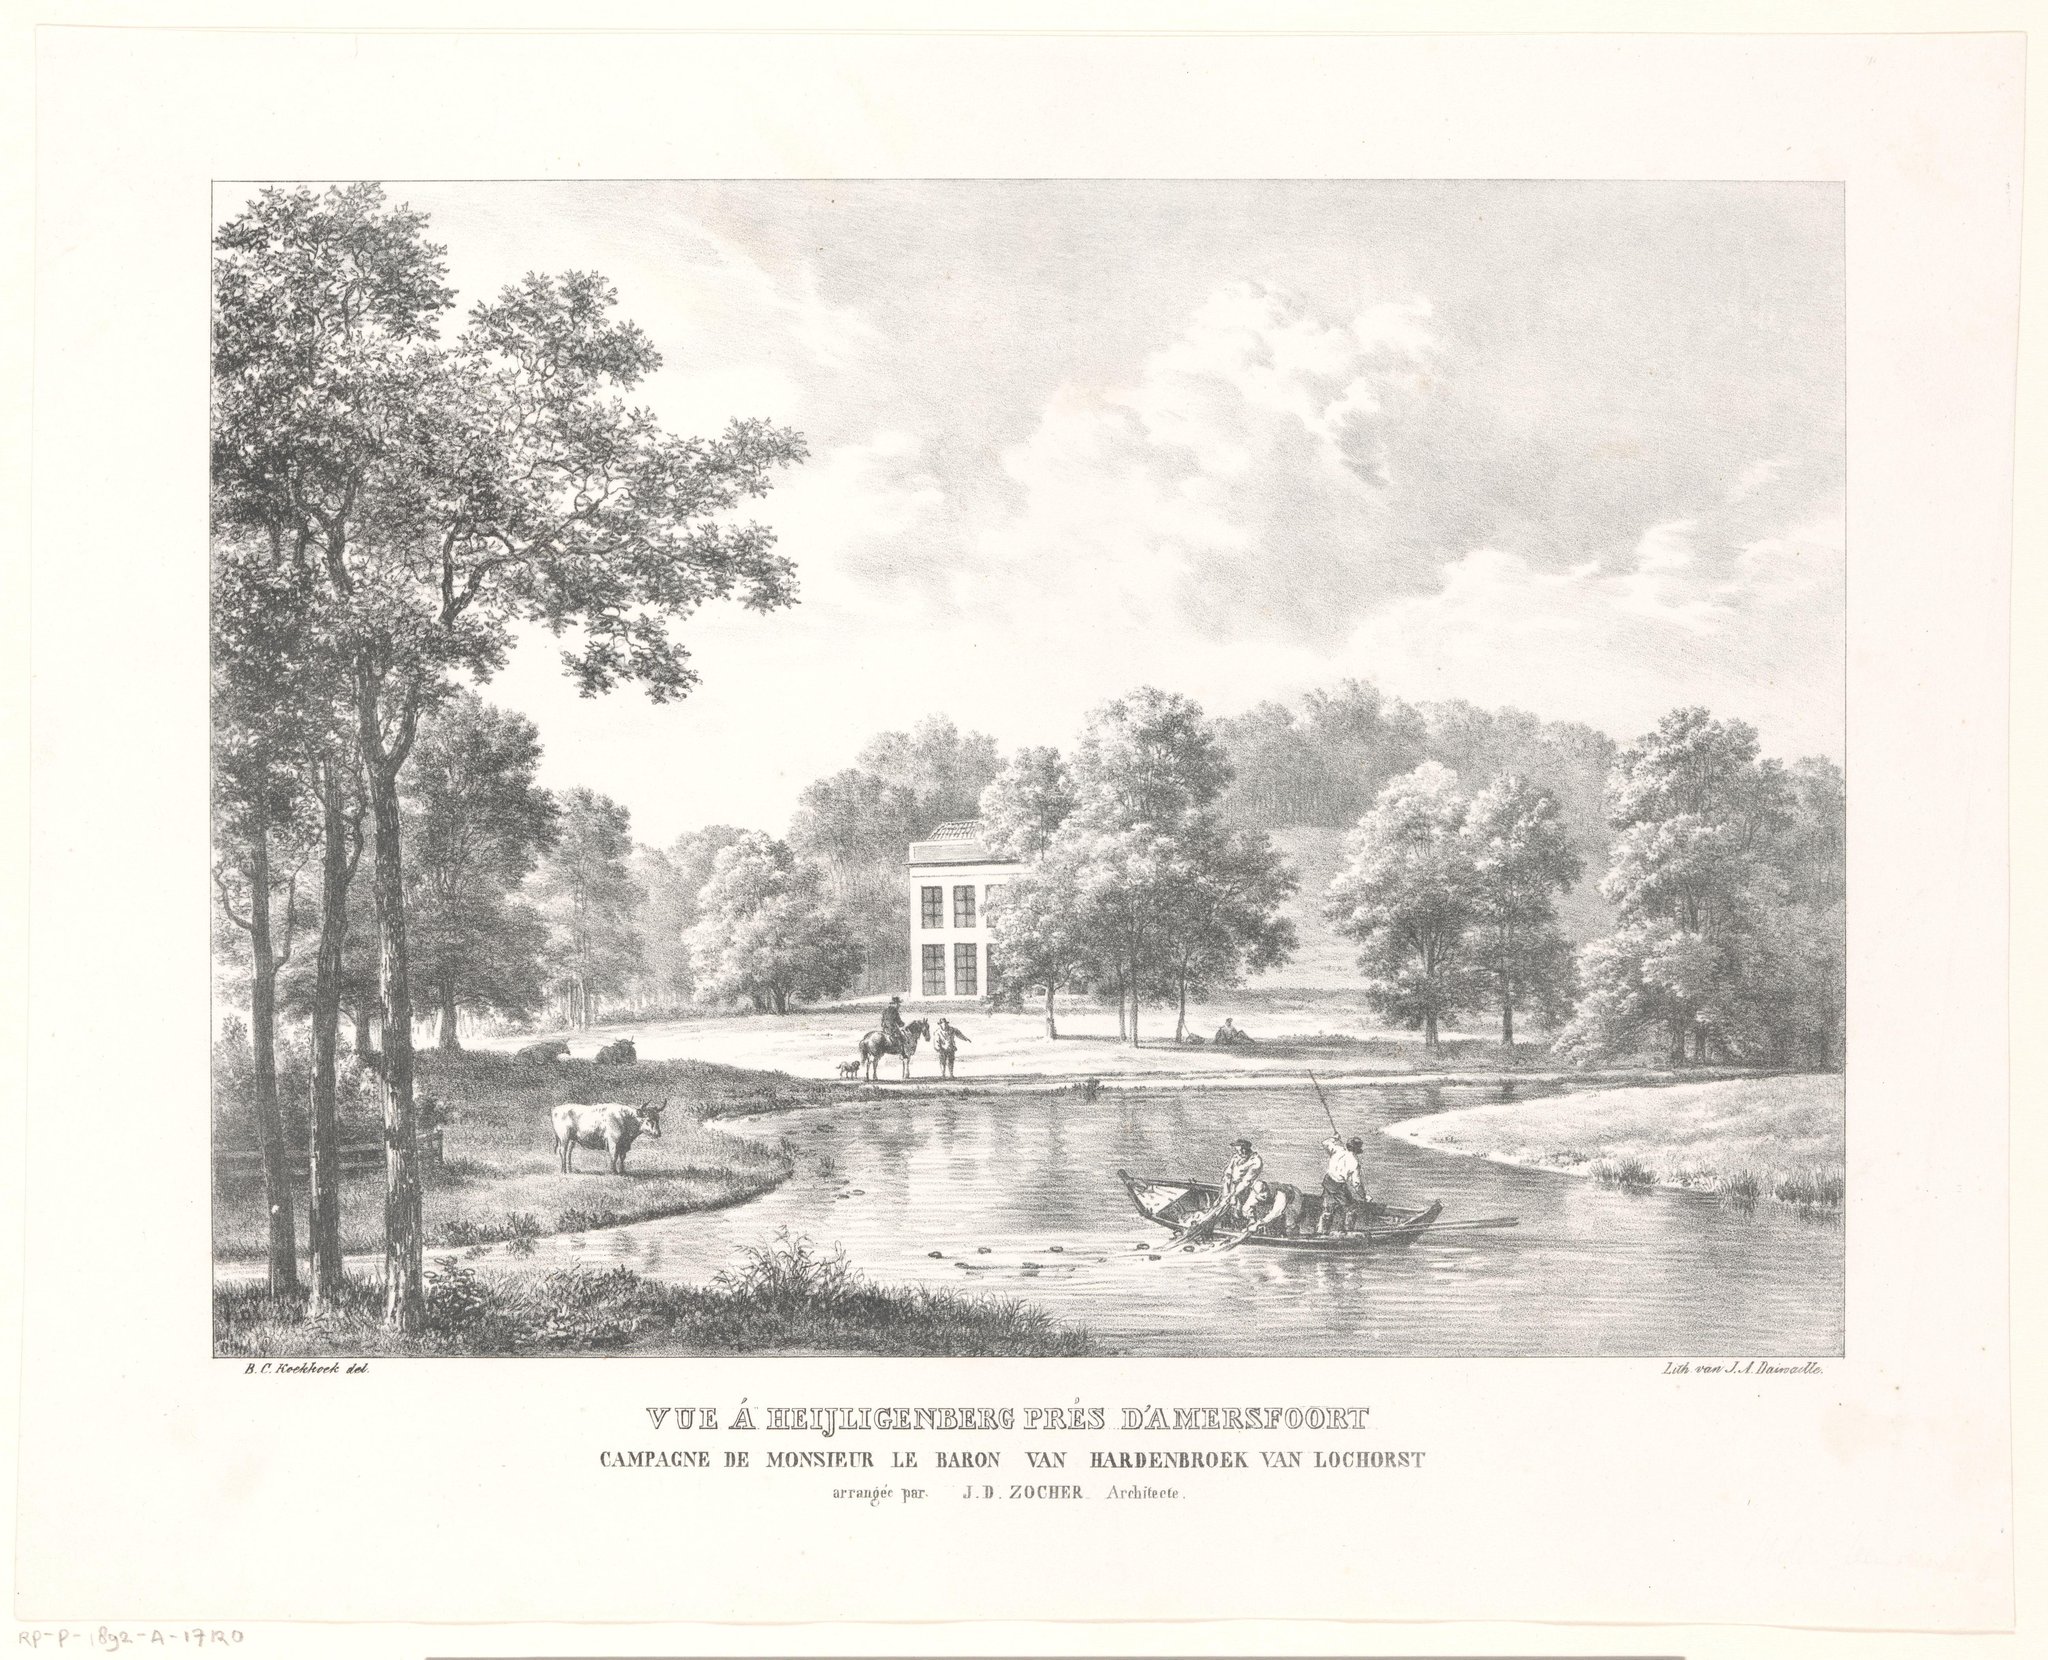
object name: print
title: Vue à Heijligenberg près d'Amersfoort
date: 1828-1830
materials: paper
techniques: lithograph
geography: amsterdam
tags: summer, 'aestas'; 'estate' (ripa), river (+ landscape with figures, staffage), fisherman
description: In een boot op het water zijn drie vissers bezig met een net. Op de oever staan en liggen koeien. Verscholen achter de bomen staat een gebouw. Onder de titel staat een onderschrift: Campagne de monsieur le Baron Van Hardenbroek van Lochorst. Arrangée par J. D. Zocher Architecte.